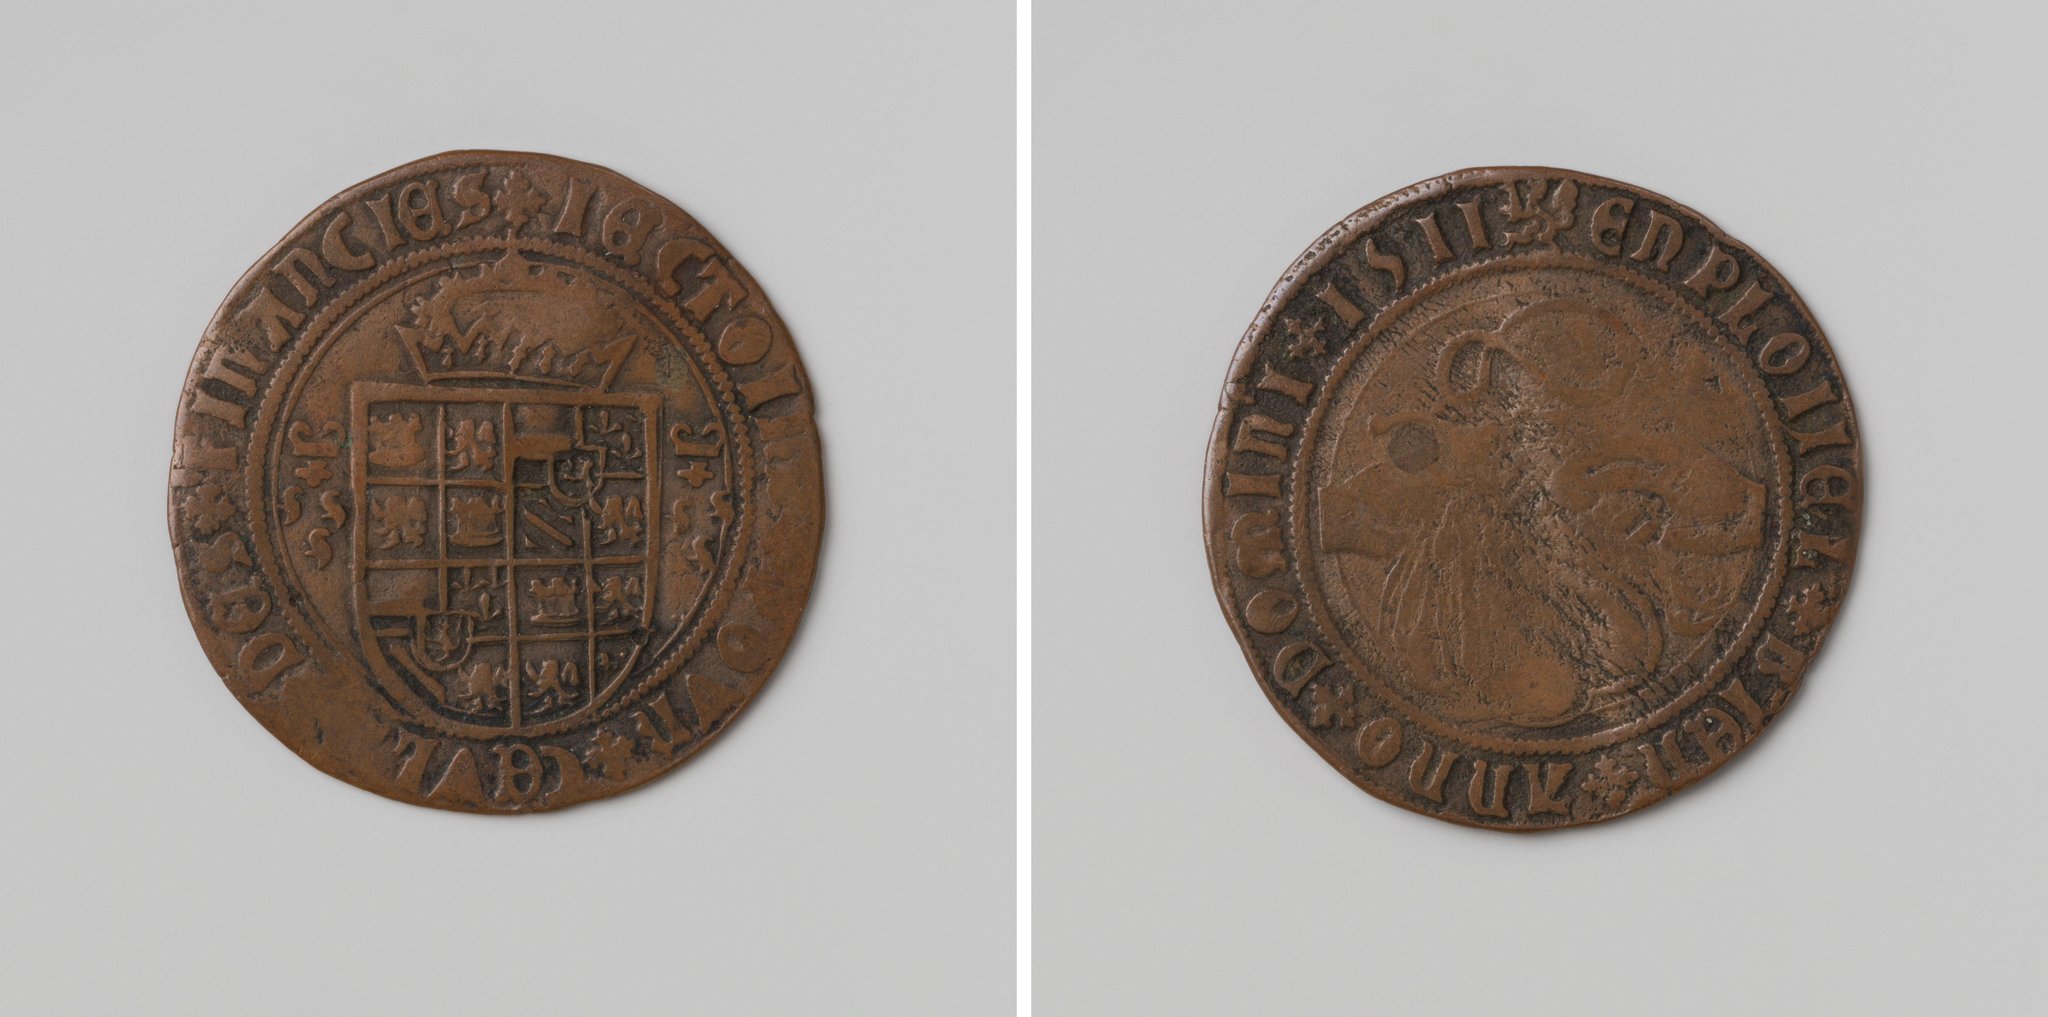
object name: jeton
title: Raad van Financiën van Karel, prins van Spanje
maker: Anonymous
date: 1511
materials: copper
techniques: striking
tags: ghent, charles v (holy roman emperor and king of spain)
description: Koperen penning. Voorzijde: gekroond wapenschild, geflankeerd door twee vuurslagen, waar vonken uit schieten binnen omschrift. Keerzijde: ene hand geeft andere, die beurs in hand houdt, een muntstuk binnen omschrift